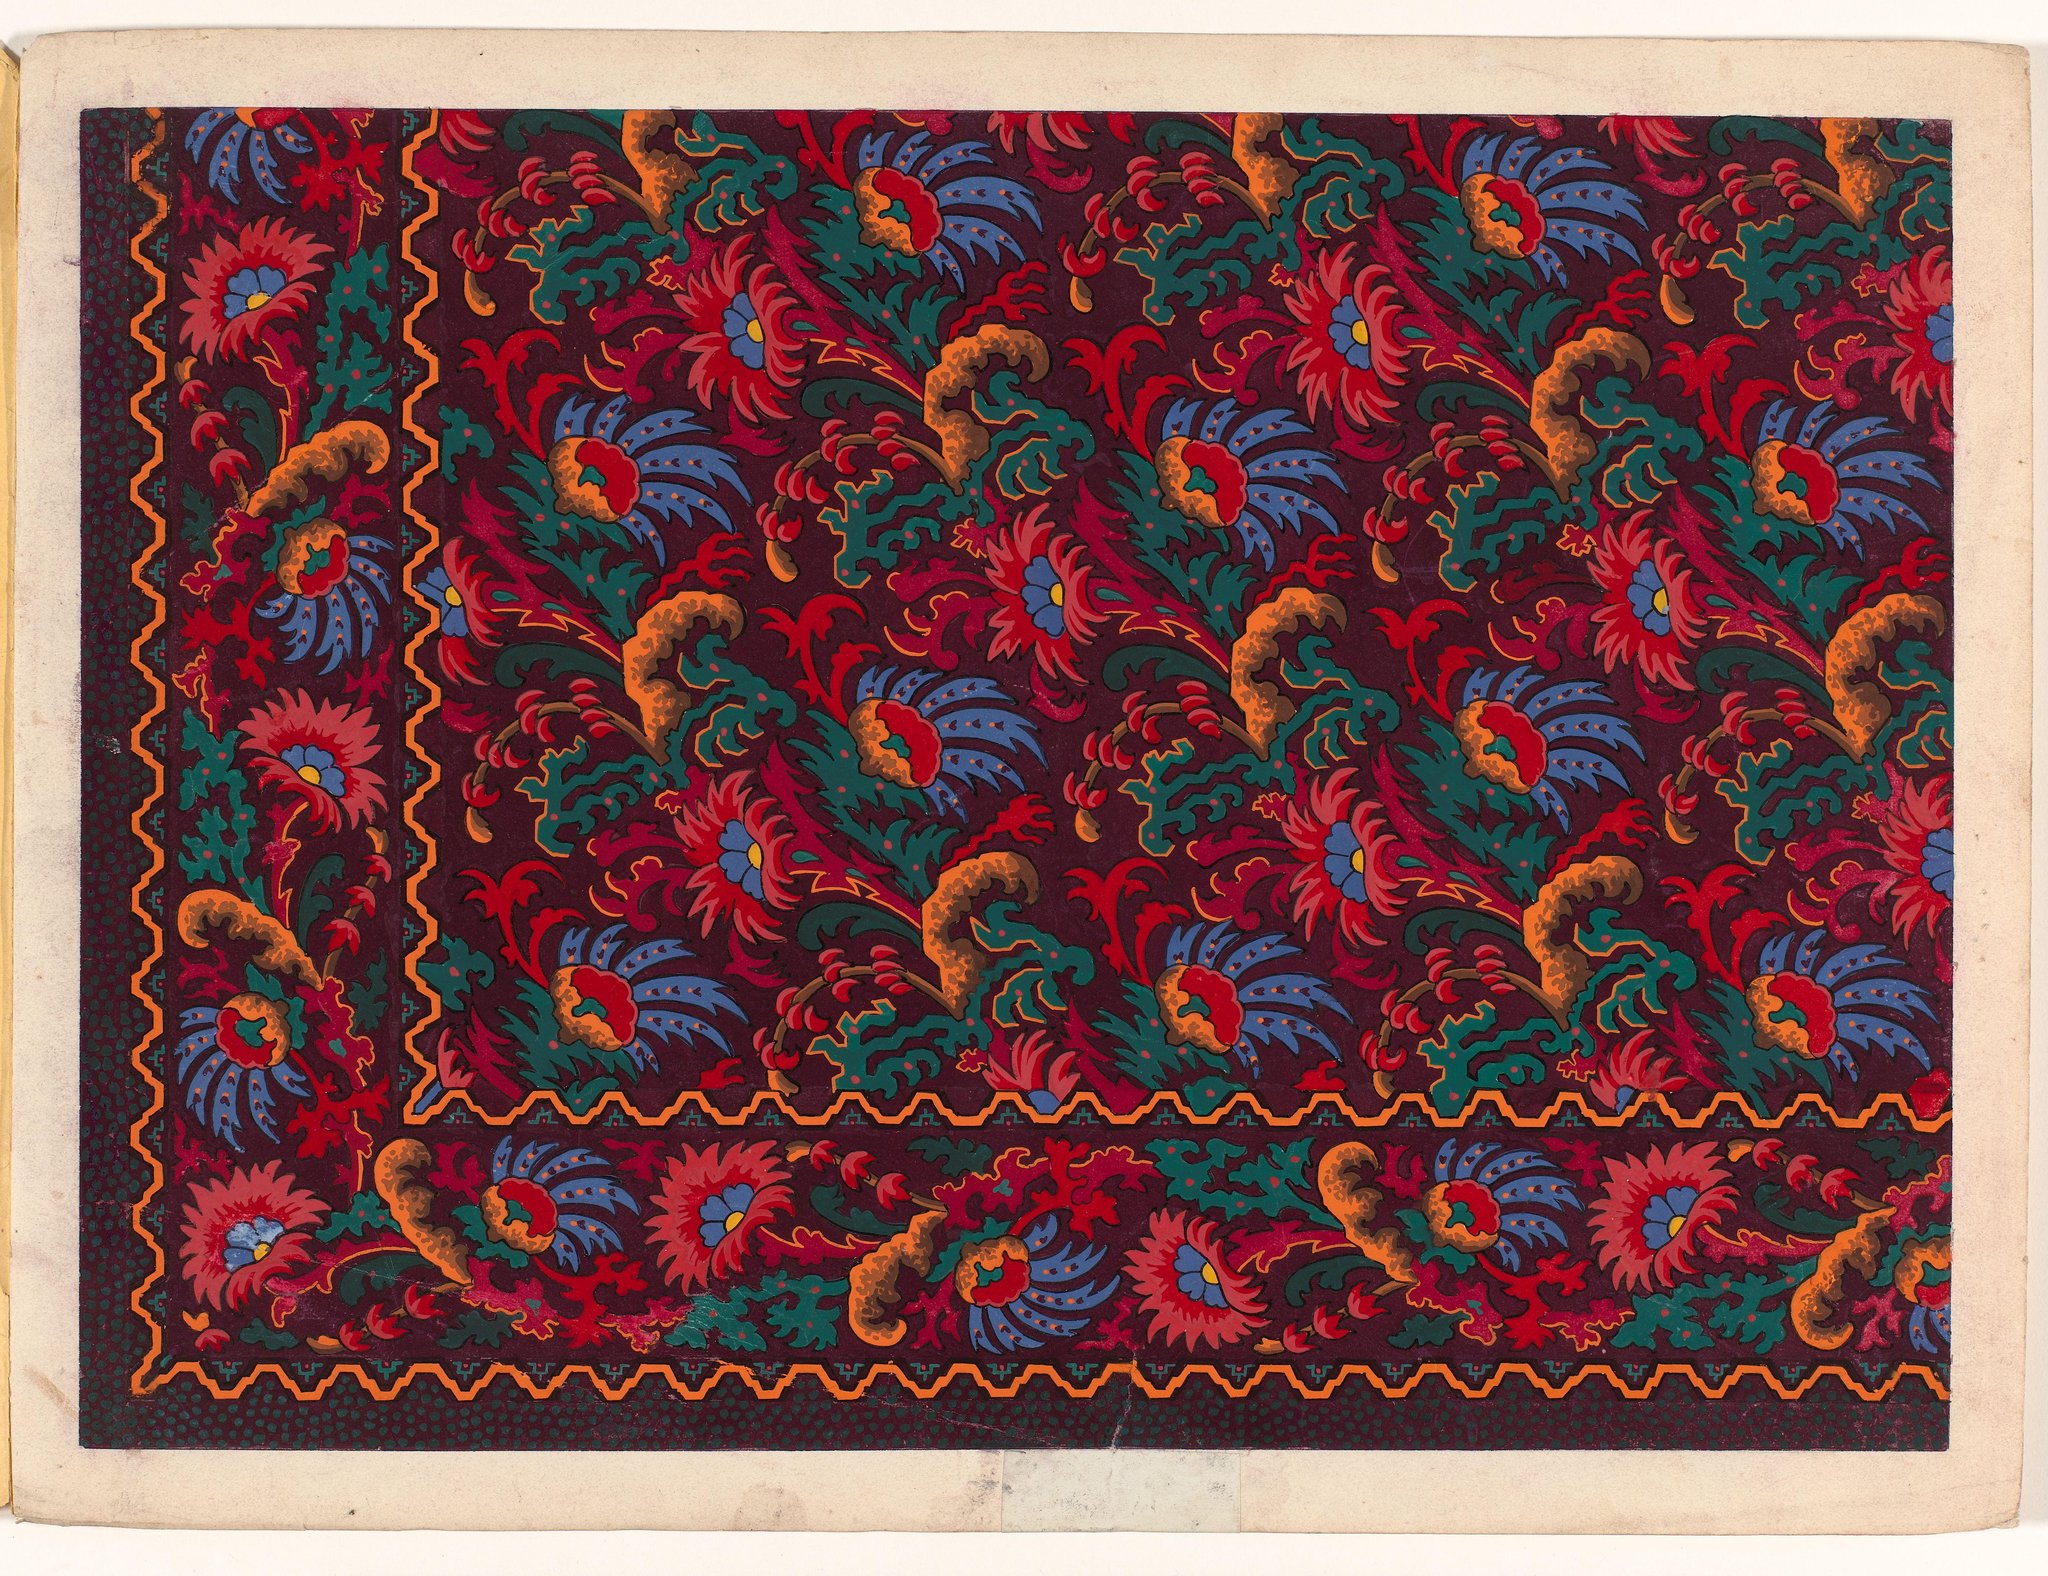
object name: drawing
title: Ontwerp voor een tapijt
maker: Anonymous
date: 1864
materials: gouache, paper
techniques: brush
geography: amsterdam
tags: ornaments ~ art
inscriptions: retailer's mark: ‘JHS.’, number: ‘No 379 B.’, inscription: ‘Brief 1 Aug 1864 f4.-’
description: De presentatietekeningen BK-1971-77-1 t/m 86 zijn kopieën van de originele ontwerptekeningen. Ze werden gemaakt voor vertegenwoordigers van bijvoorbeeld magazijnen, die ze aan hun klanten konden tonen. De meeste tekeningen tonen een kwart van het dessin inclusief rand, middenpartij (de zogenaamde grond of fond) en centraal medaillon. Door het gebruik van spiegels kan de illusie van het gehele tapijt worden opgeroepen. Een deel van de tekeningen heeft een alfabetische opeenvolgende letter als kenmerk, de andere groep een cijfer.Waarschijnlijk is de reeks dessins met een letter eerder samengesteld dan de genummerde tekeningen.